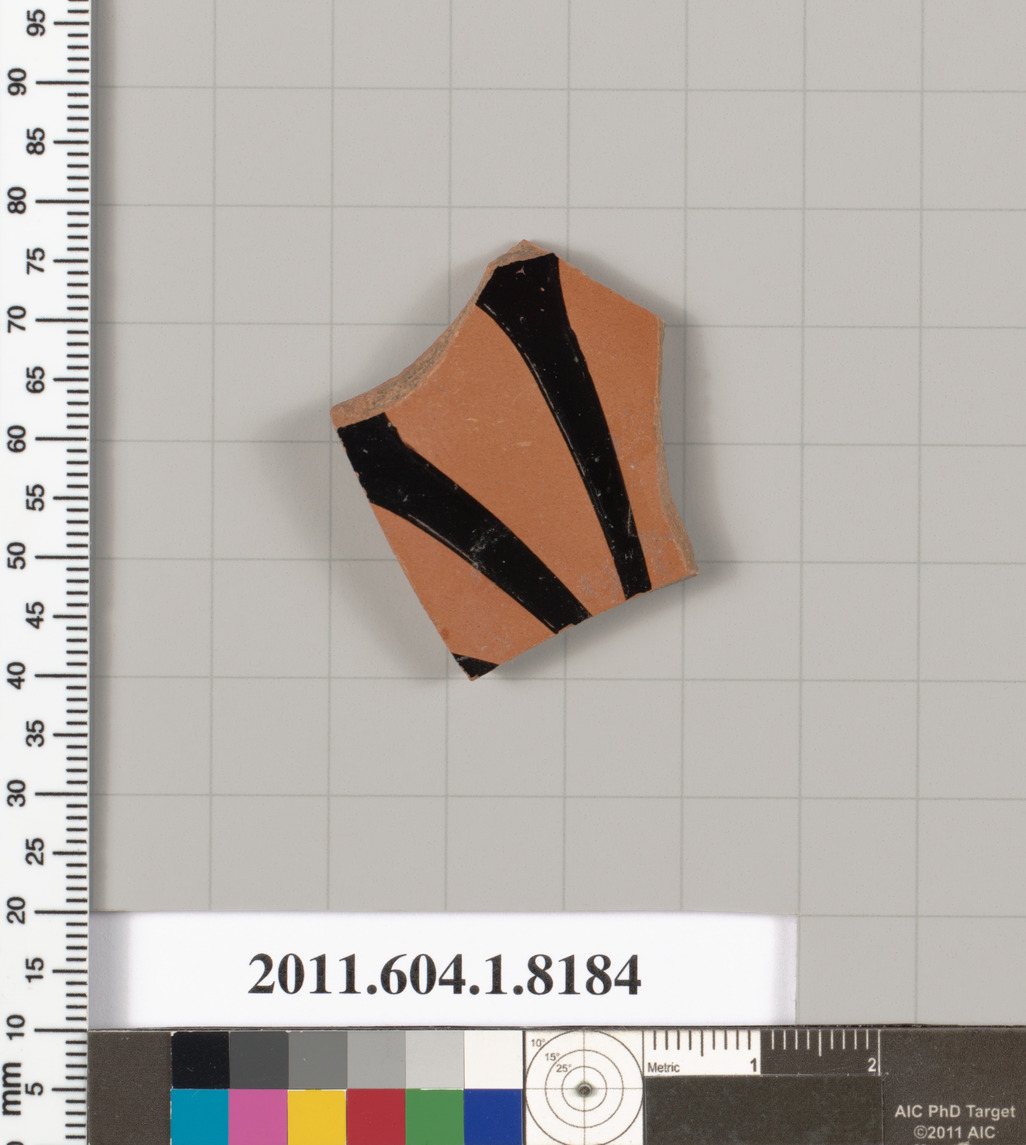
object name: kylix fragment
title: Terracotta fragment of a kylix (drinking cup)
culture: greek, attic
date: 520-510 BCE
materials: terracotta